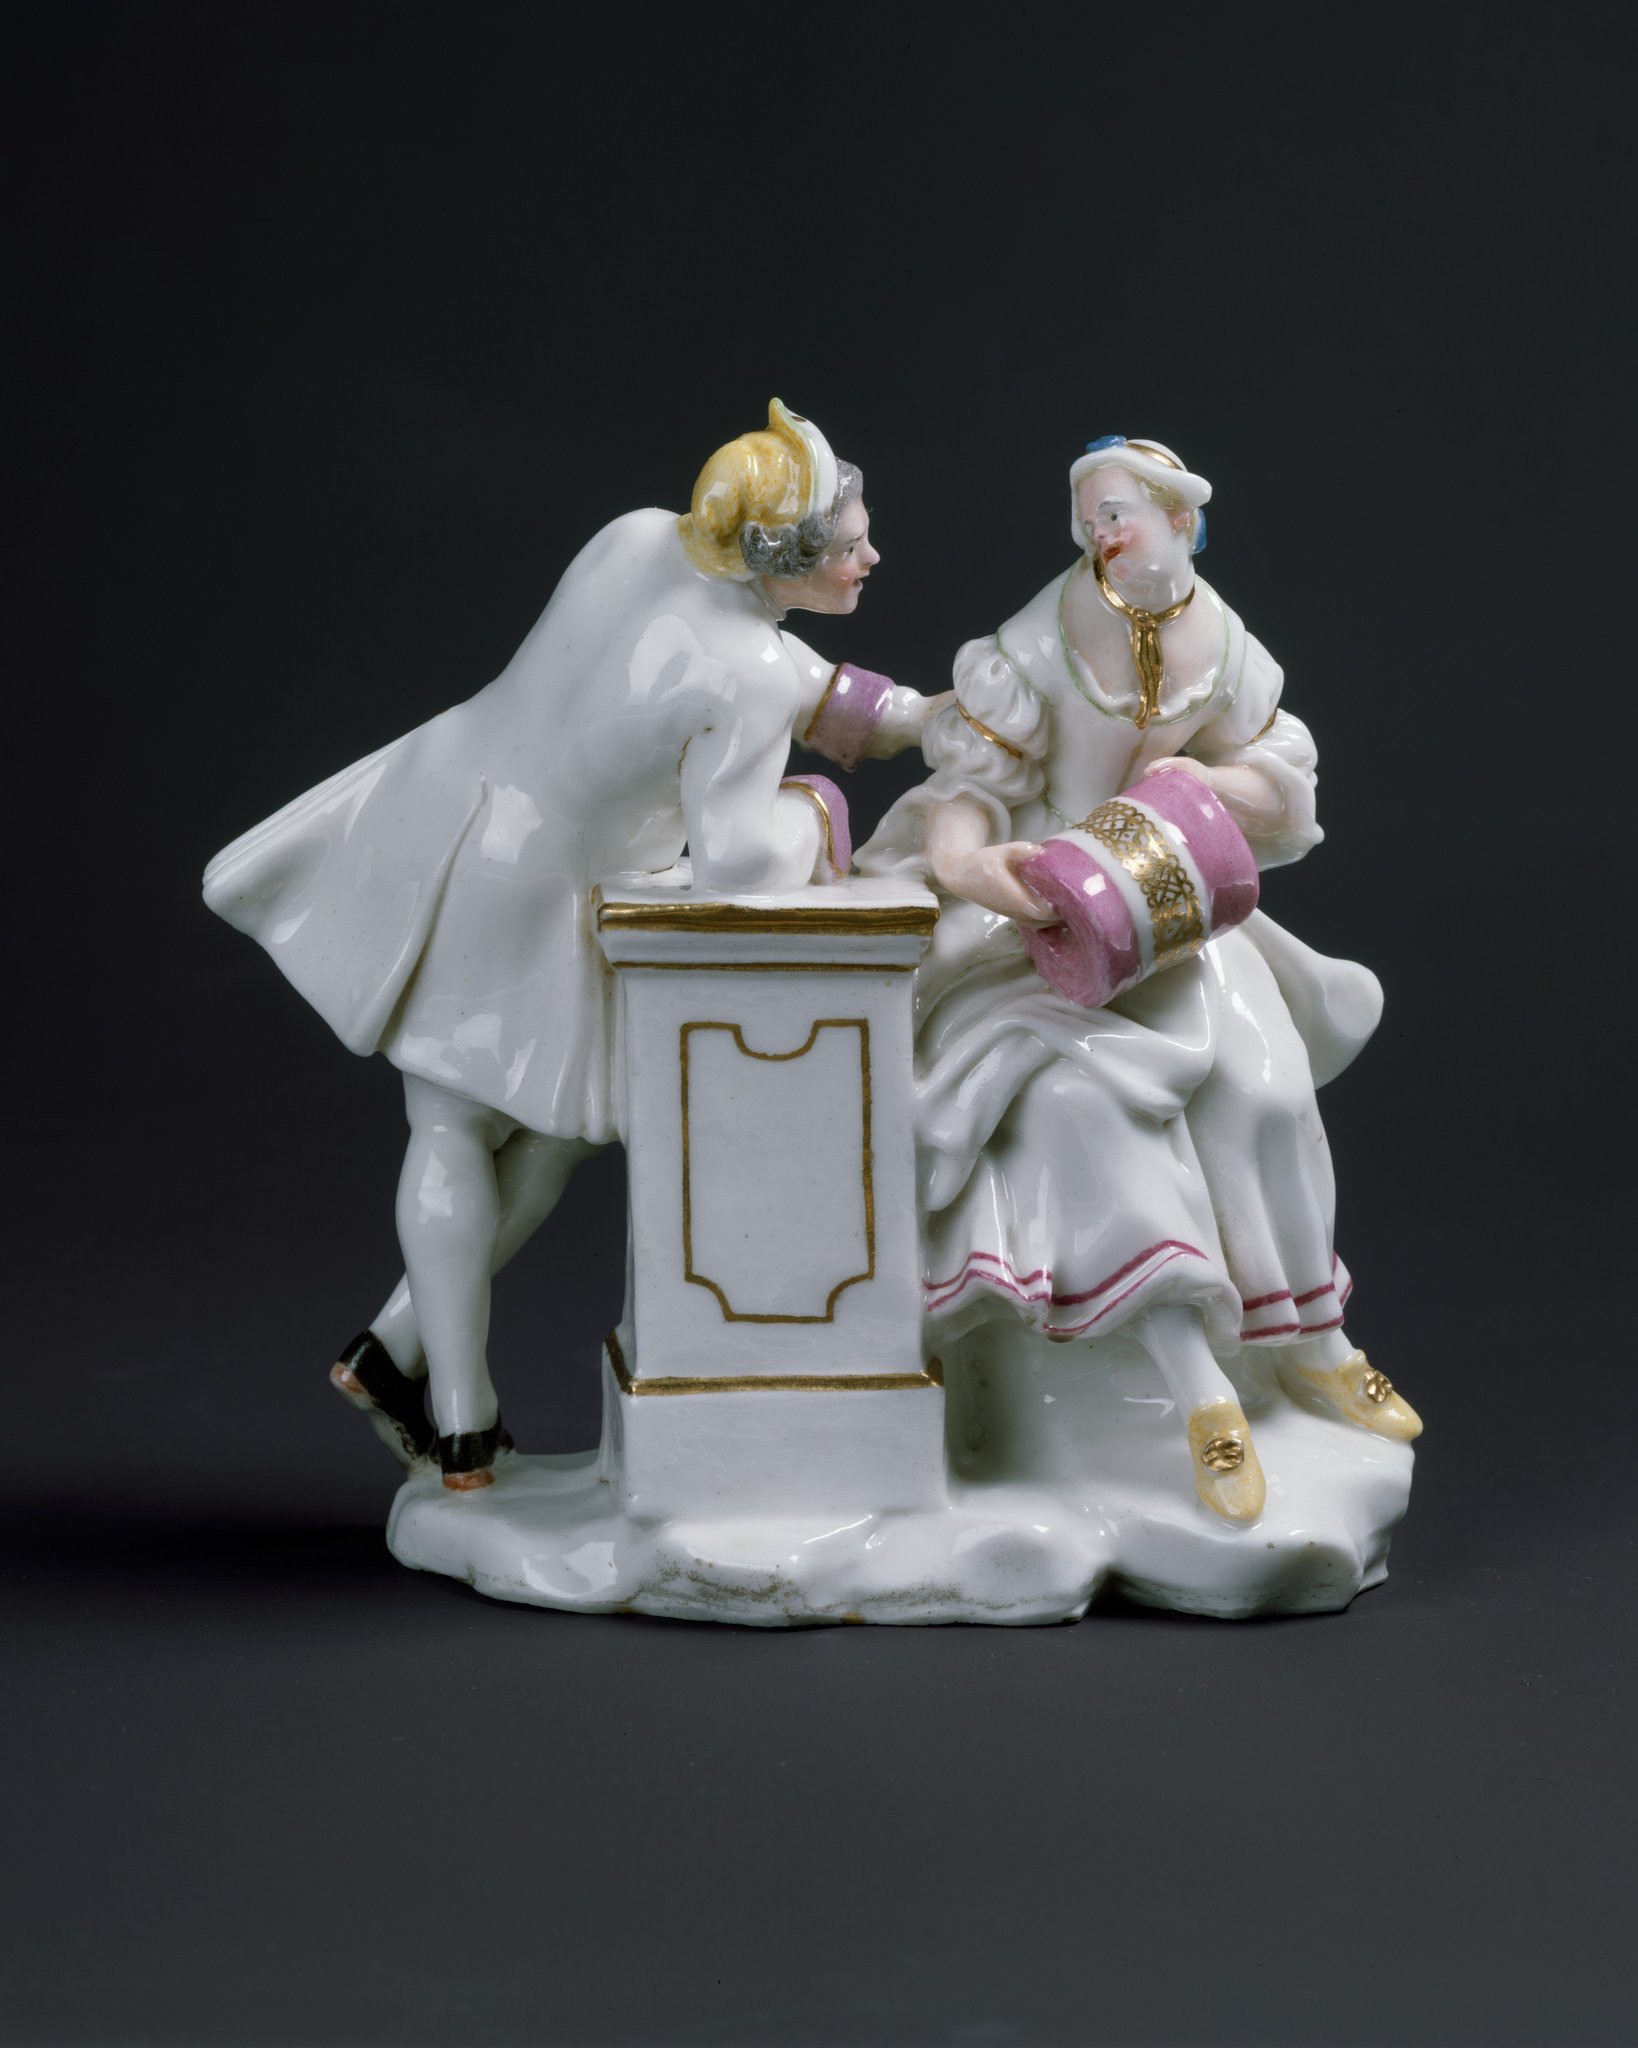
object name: group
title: Young couple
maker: capodimonte porcelain manufactory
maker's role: manufactory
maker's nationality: italian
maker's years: 1740-1759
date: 1745-1750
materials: soft paste porcelain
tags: couples,men,women